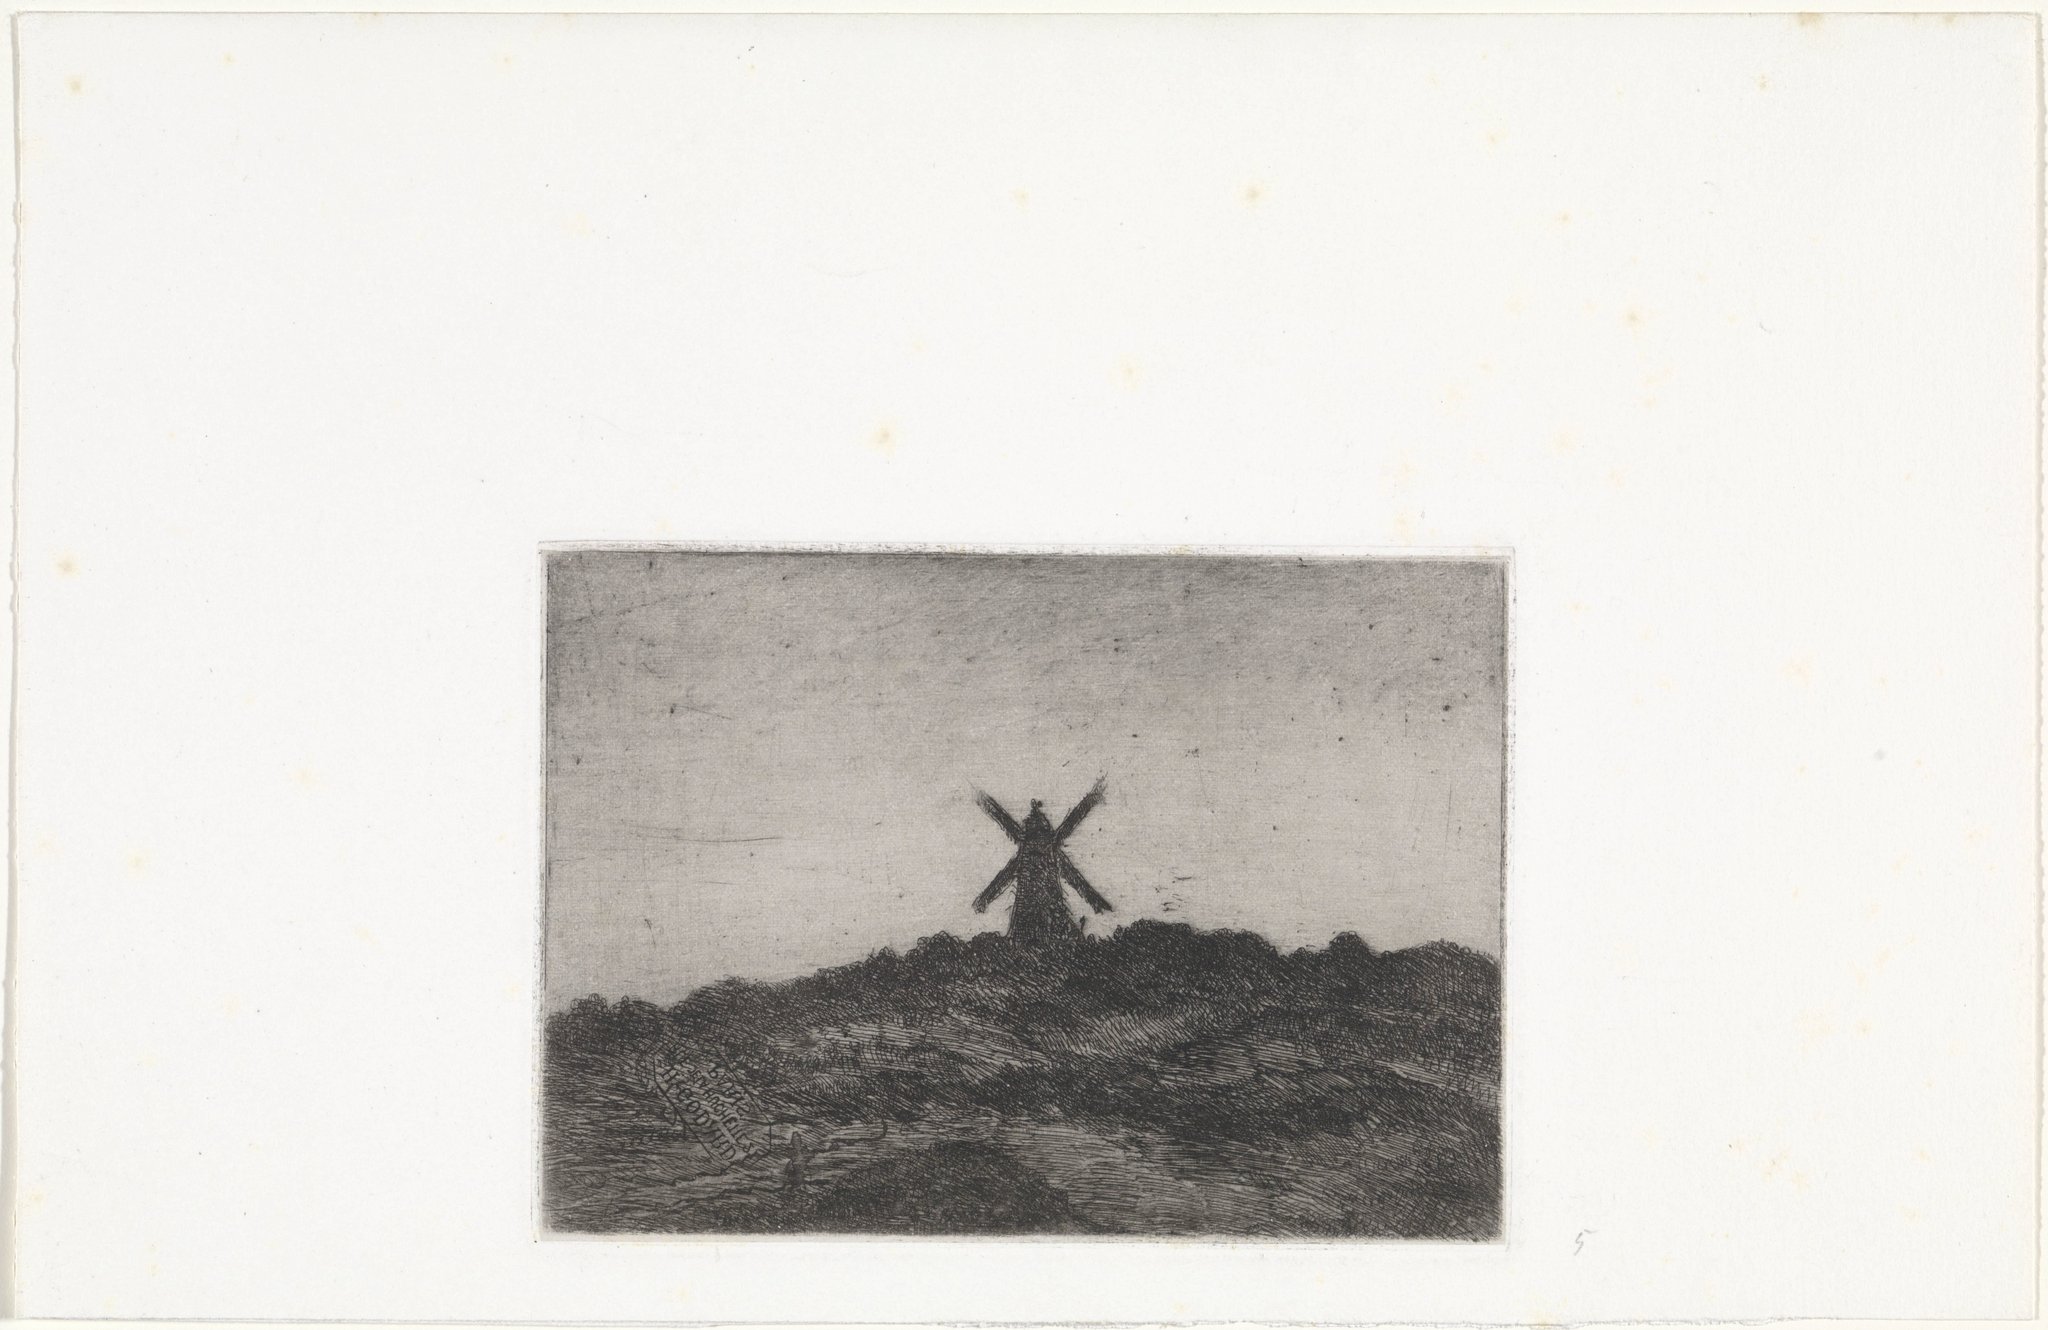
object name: print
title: Molen in een duinlandschap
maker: arnoud schaepkens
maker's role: print maker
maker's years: 1816-1904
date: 1855-1904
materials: paper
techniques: drypoint, etching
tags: dunes (sea not visible); in the dunes, watermill in landscape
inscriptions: collector's mark: Lugt 2228, stamp: ‘H.Godard / Rue de la Huchette 27 / Paris (in spiegelbeeld)’